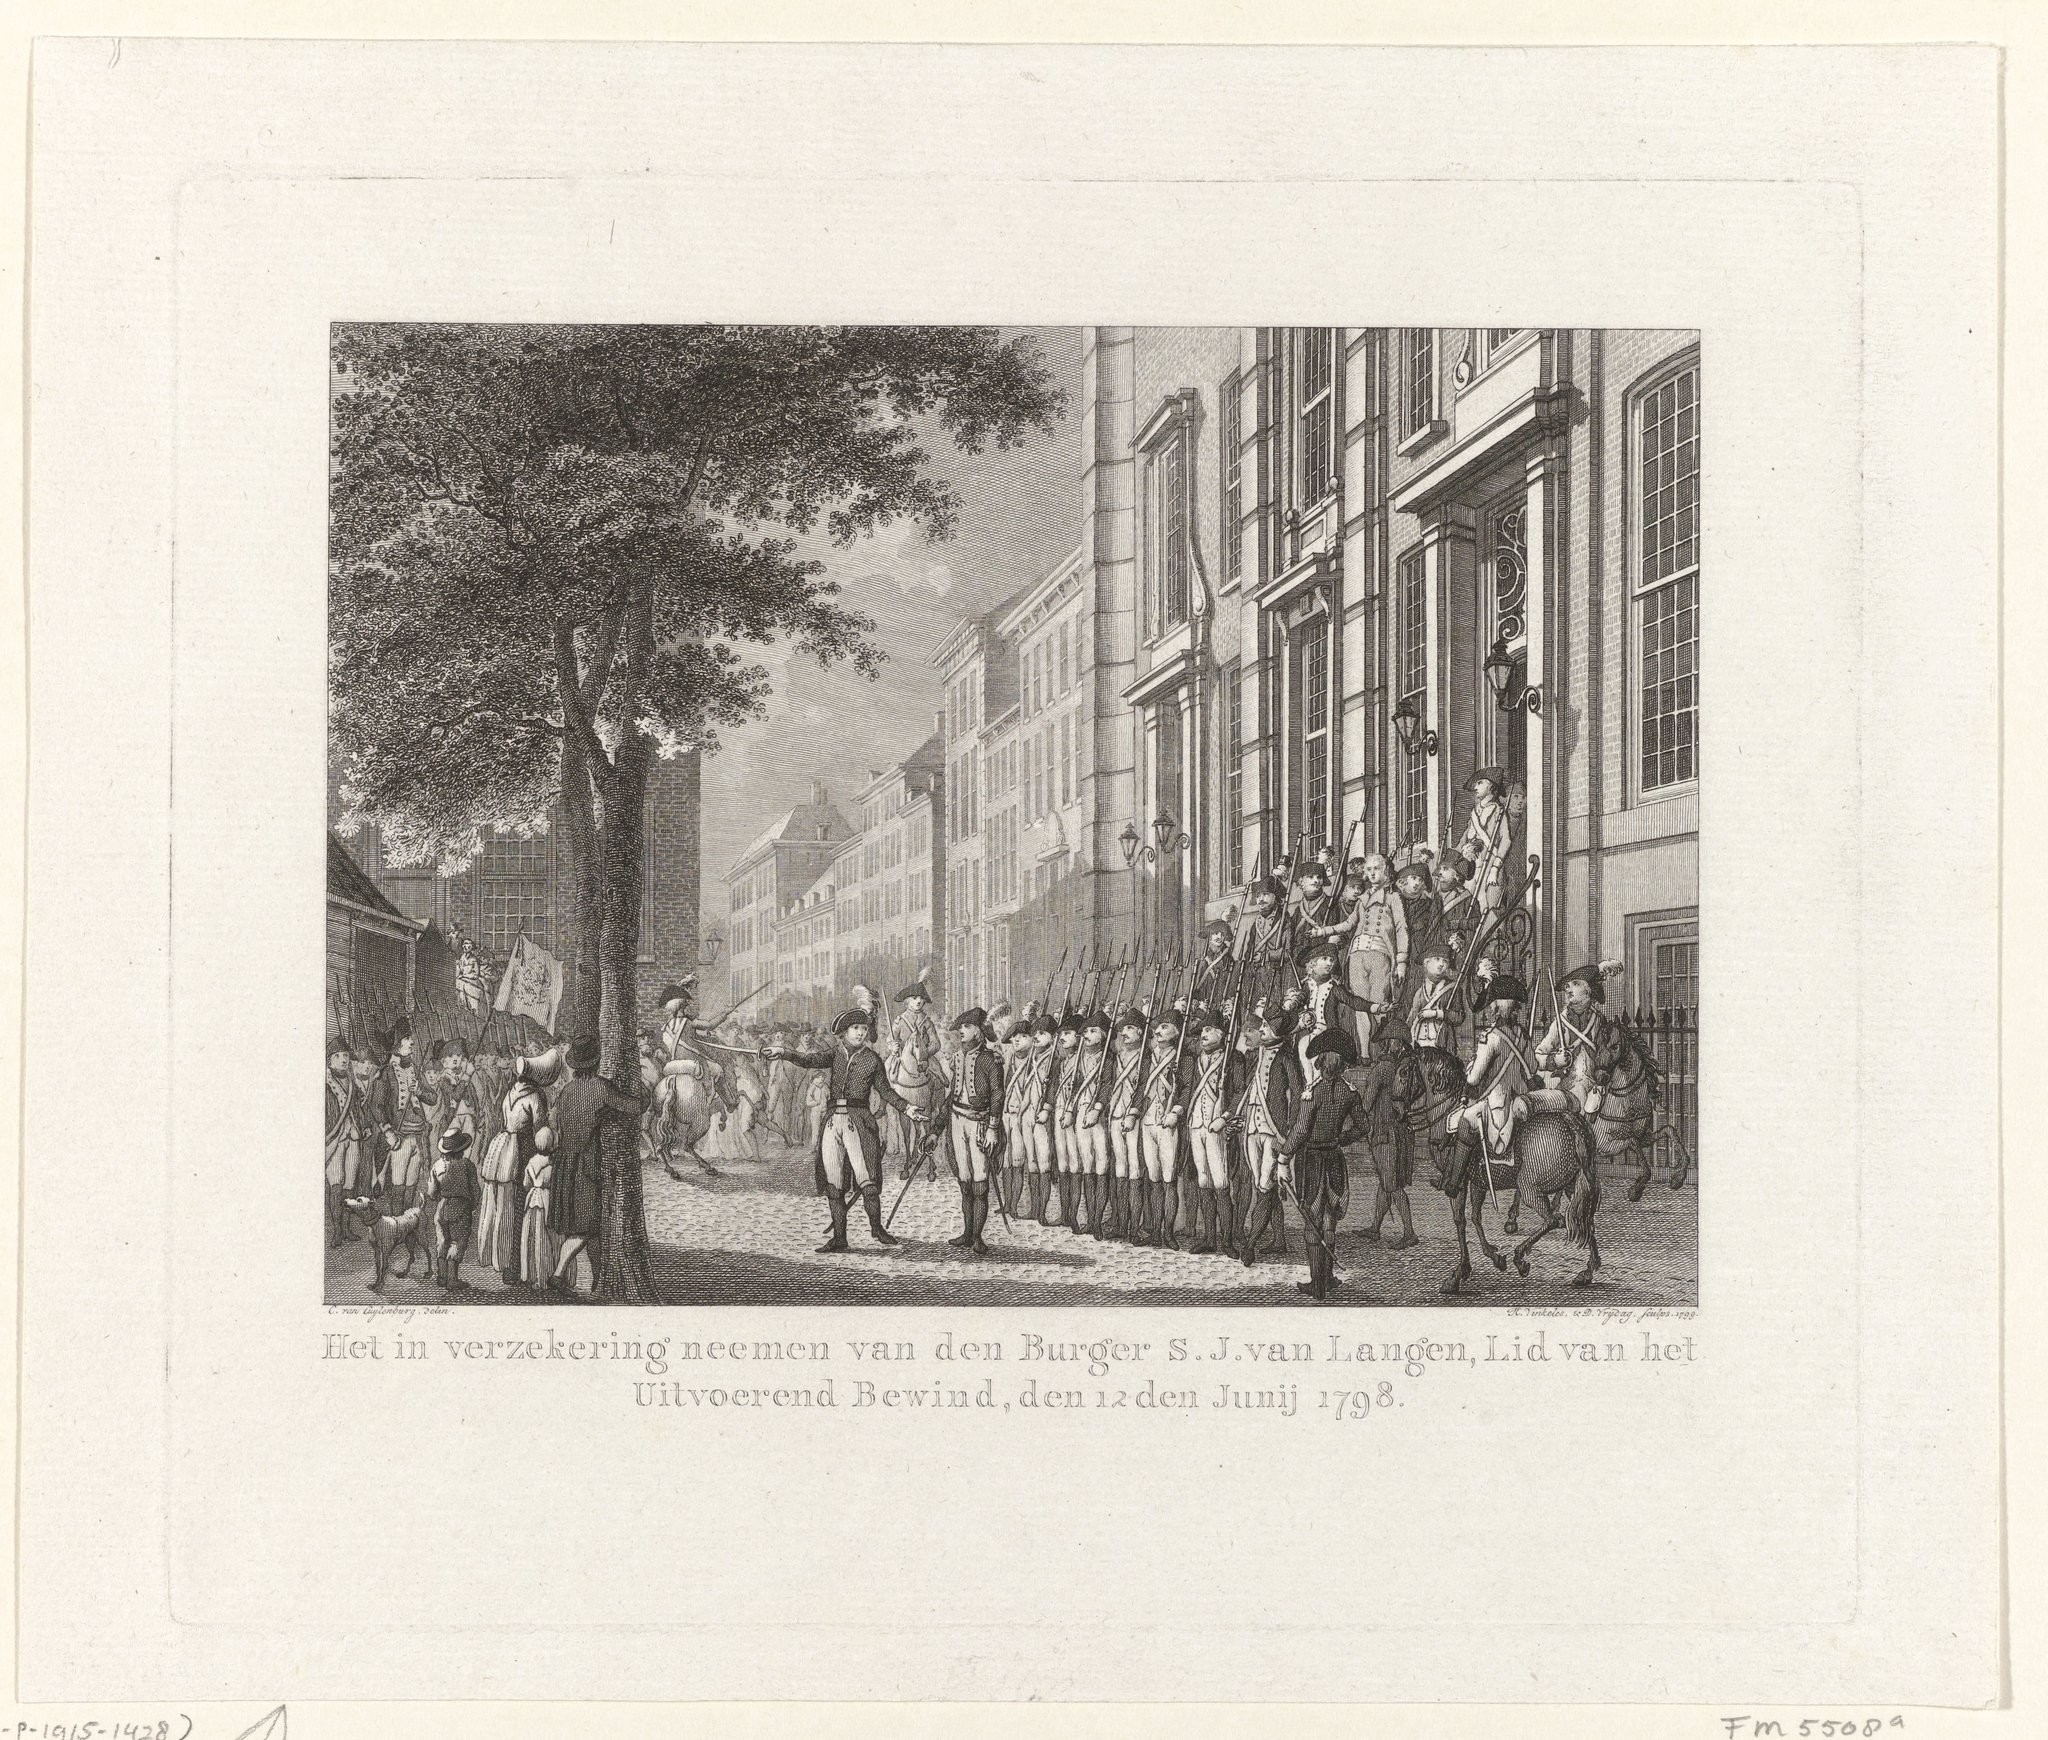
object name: print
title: Het in verzekering neemen van den Burger S.J. van Langen, Lid van het Uitvoerend Bewind, den 12den Junij 1798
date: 1799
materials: paper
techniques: engraving, etching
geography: netherlands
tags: leiden, arrest (of criminal)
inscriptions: collector's mark: Lugt 2228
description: Arrestatie van Stephanus Jacobus van Langen, lid van het Uitvoerend Bewind, door een detachement militairen vóór het Logement aan het Plein te Den Haag,12 juni 1798. Op beschuldiging van zelfverrijking.